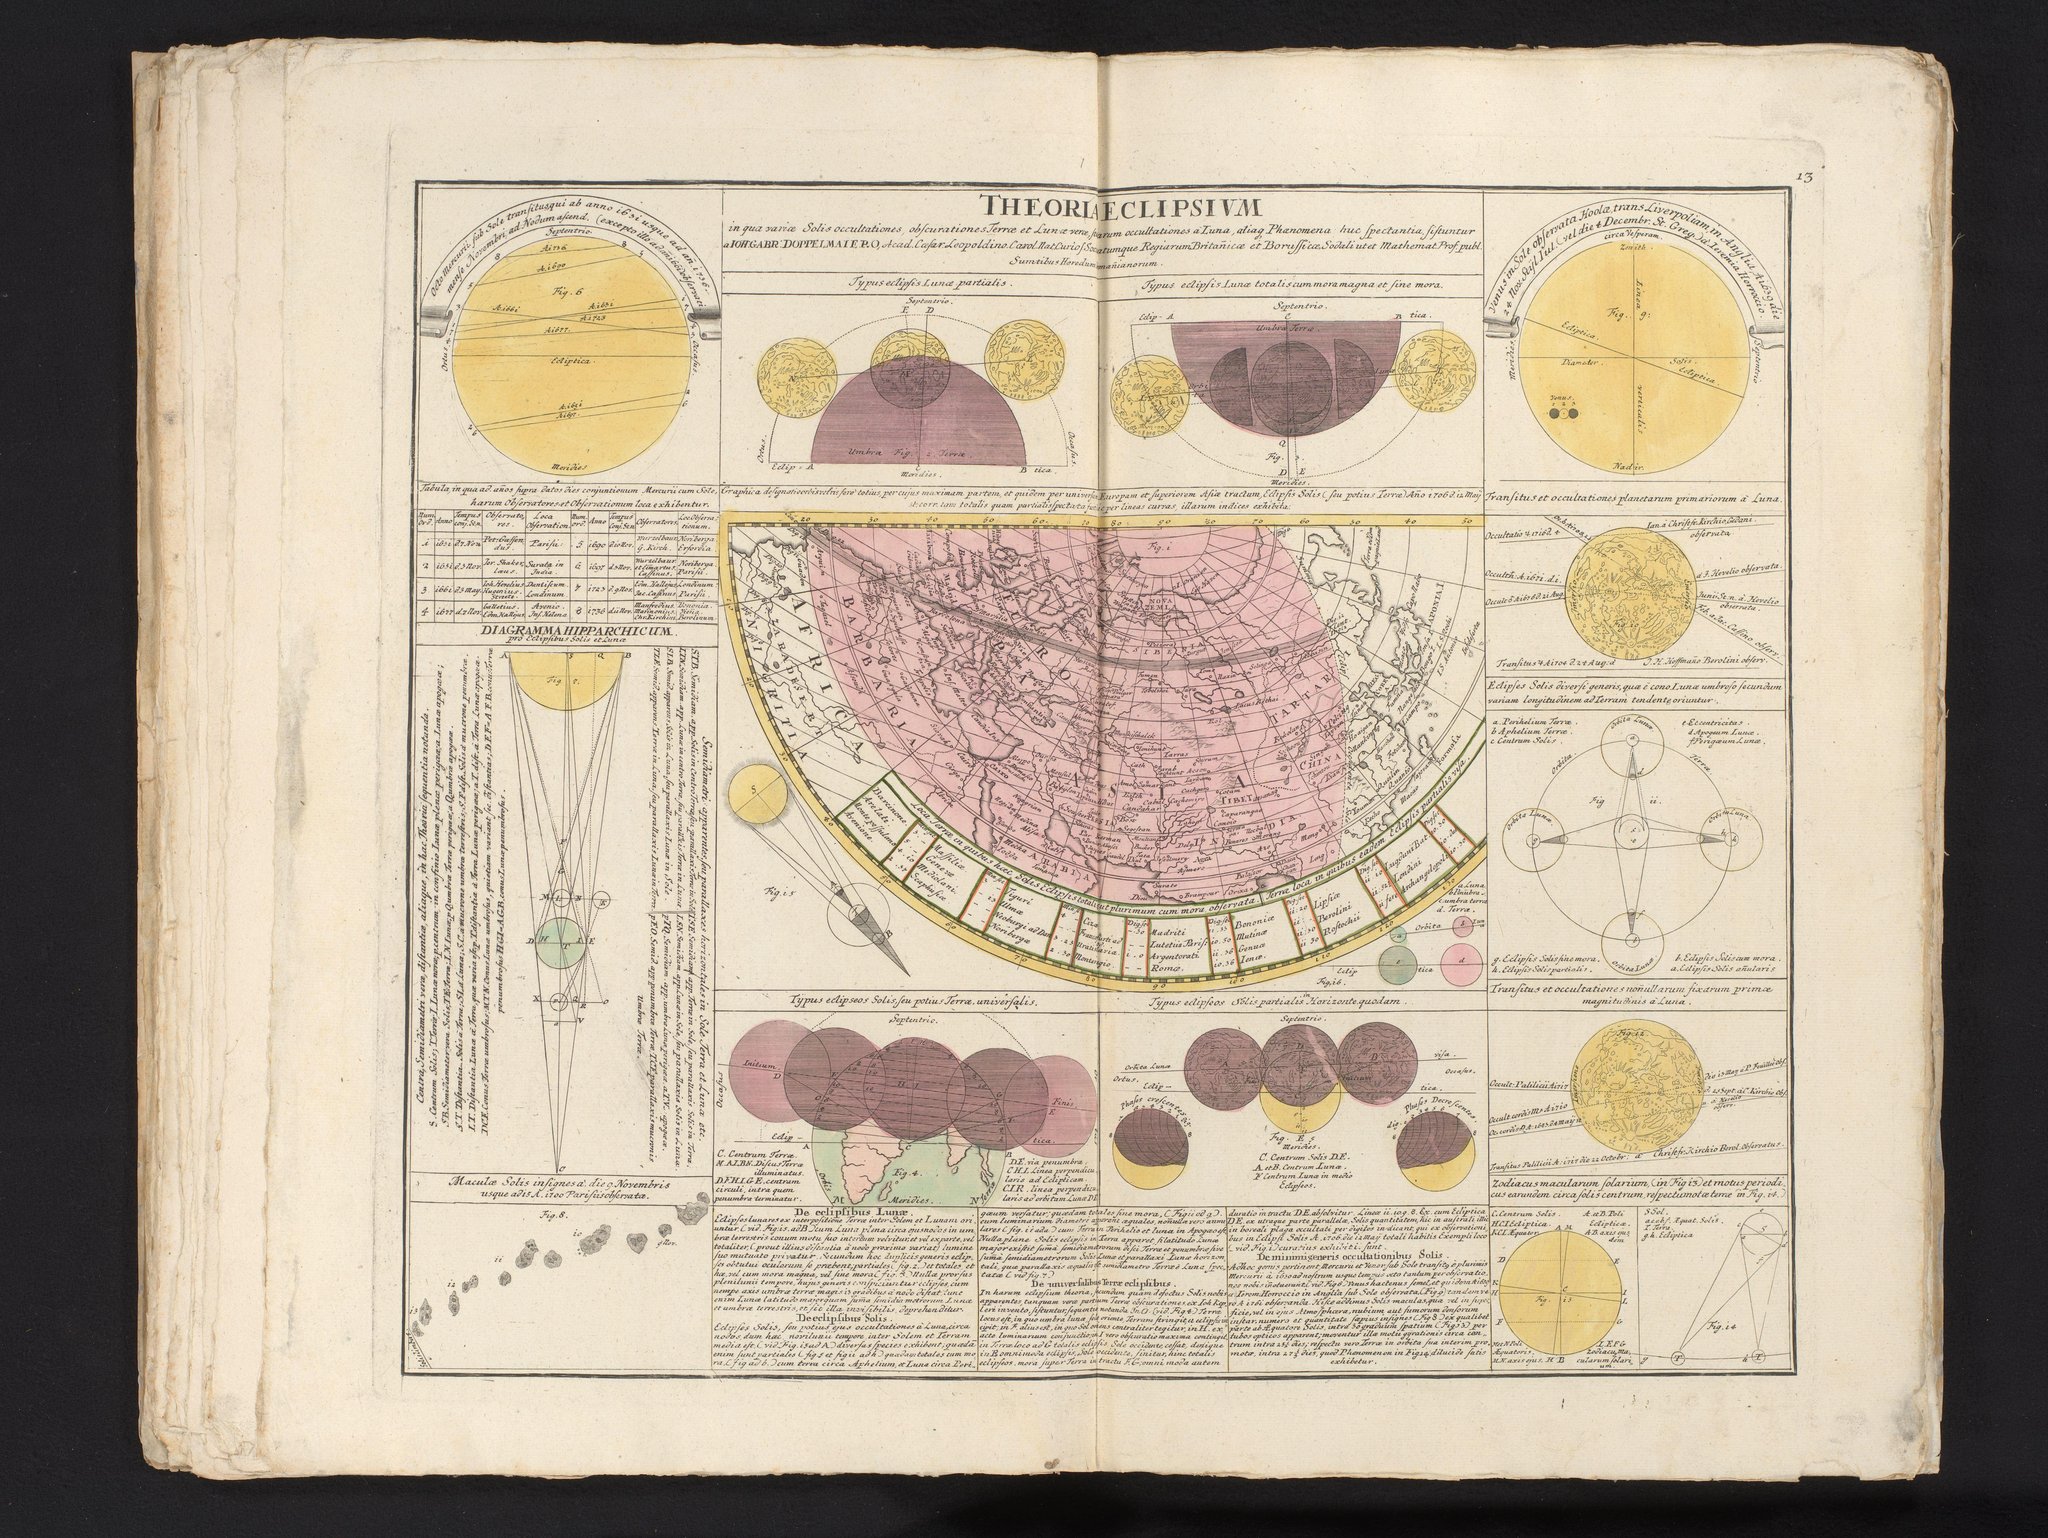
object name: print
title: Theoria eclipsium in qua variae Solis occultationis, obscurationes Terrae et Lunae (...)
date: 1742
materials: paper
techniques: engraving, etching, hand coloring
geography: nuremberg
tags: eclipse of the moon, solar eclipse